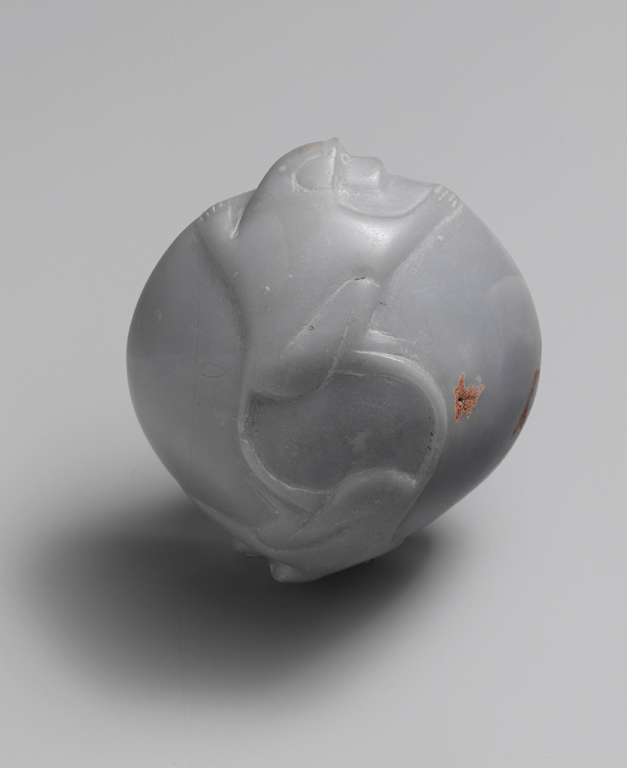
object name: ointment bowl, baboon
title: Ointment Bowl with Two Monkeys in Relief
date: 1800-1550 BCE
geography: egypt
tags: monkeys